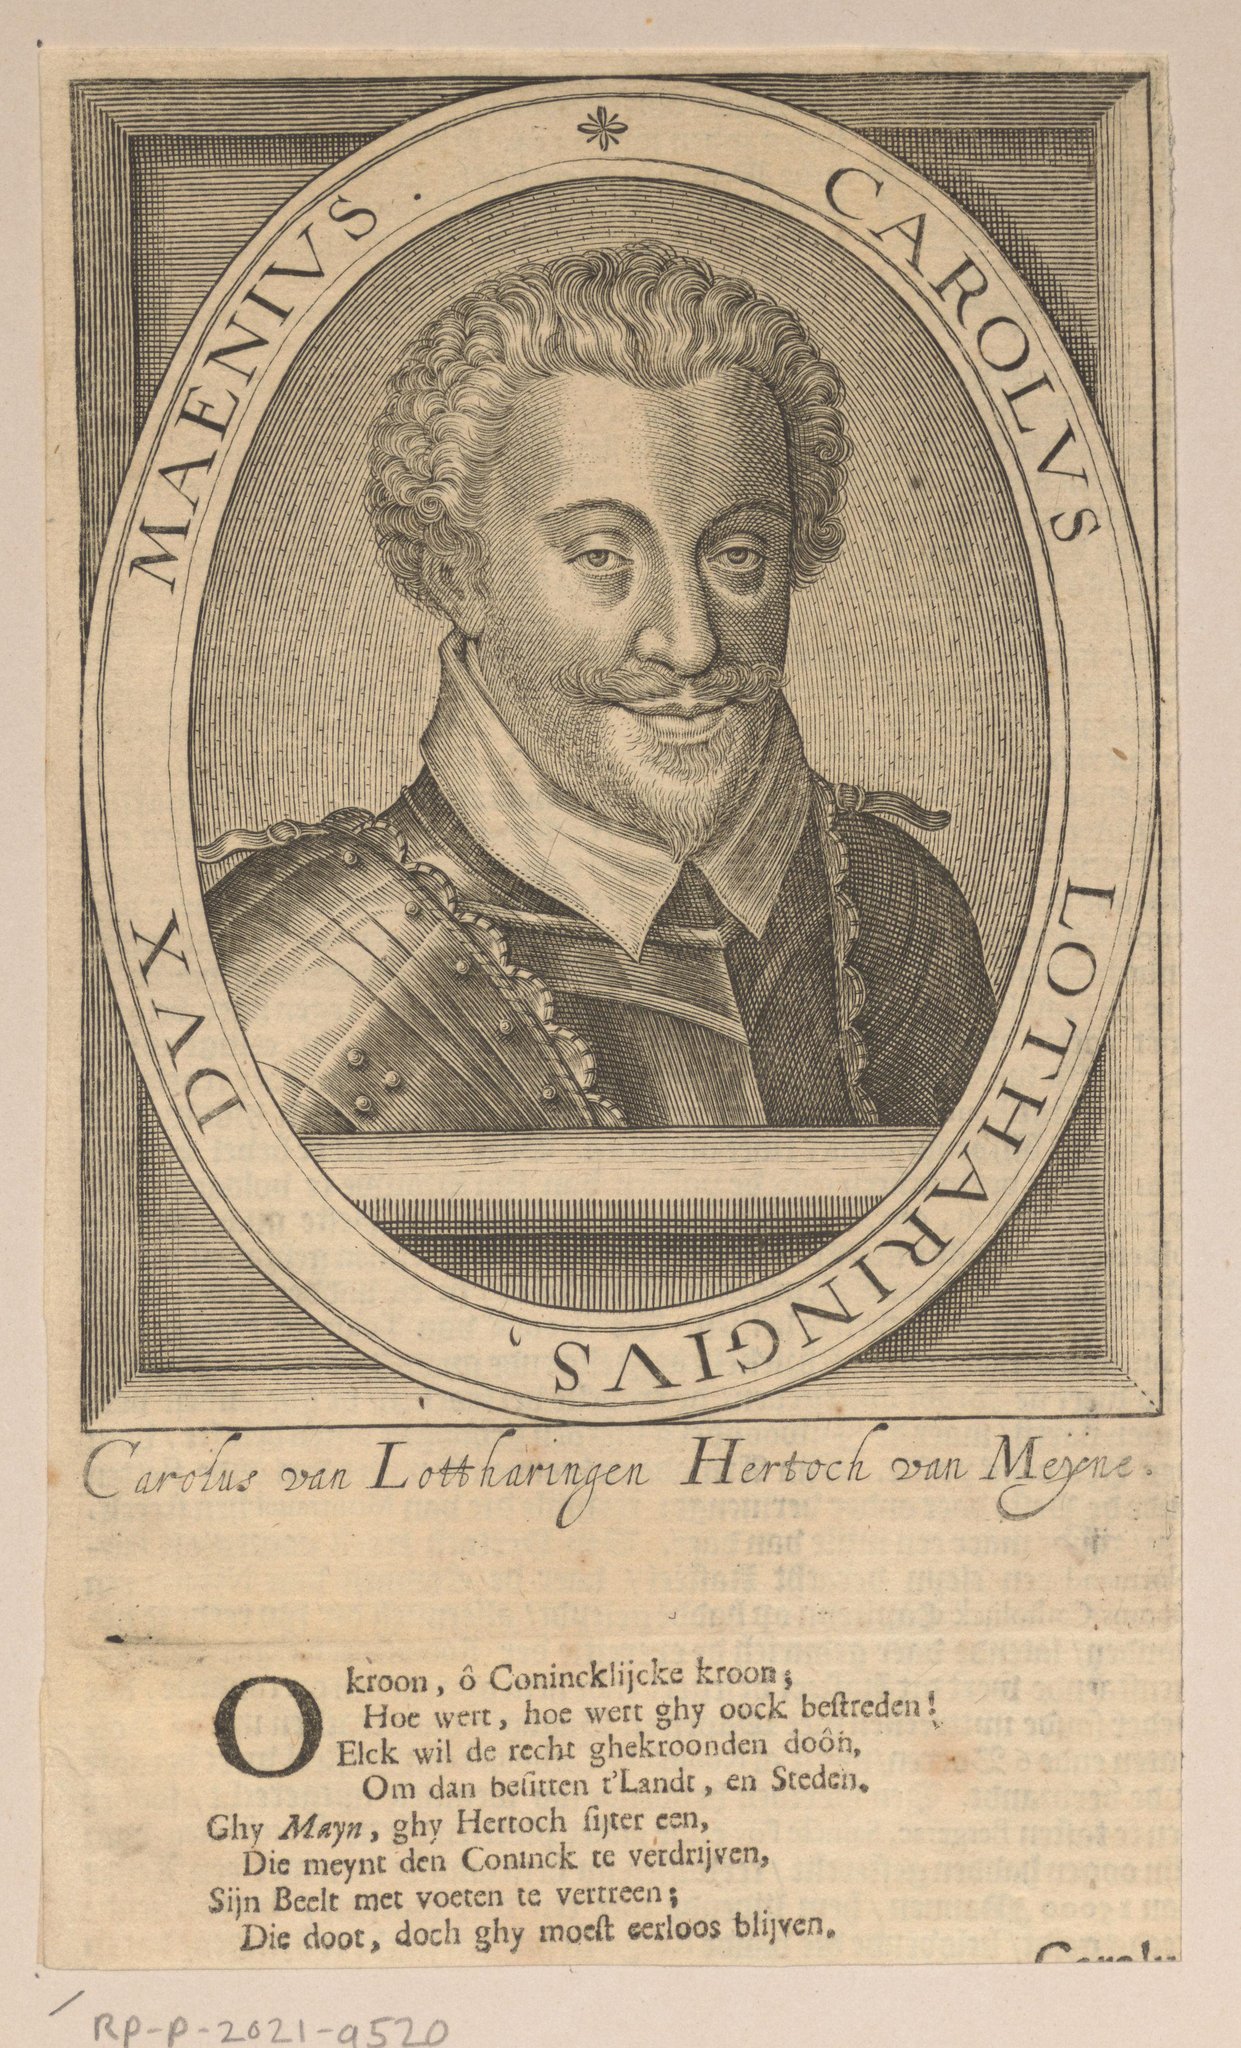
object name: book illustration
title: Carolus van Lottharingen, Hertoch van Meijne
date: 1617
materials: paper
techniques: engraving, letterpress printing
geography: northern netherlands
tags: armour, historical persons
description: Prent uit: Tooneel der beroemder hertogen princen, graven ende krygs-helden (...). Delft: Nicolaes de Clerck, 1617. Prent in ieder geval nog gebruikt in Van Meterens 'Historie der Neder-landscher ende haerder na-buren oorlogen (...)', 1614, en in de editie uit 1623 en 1652.